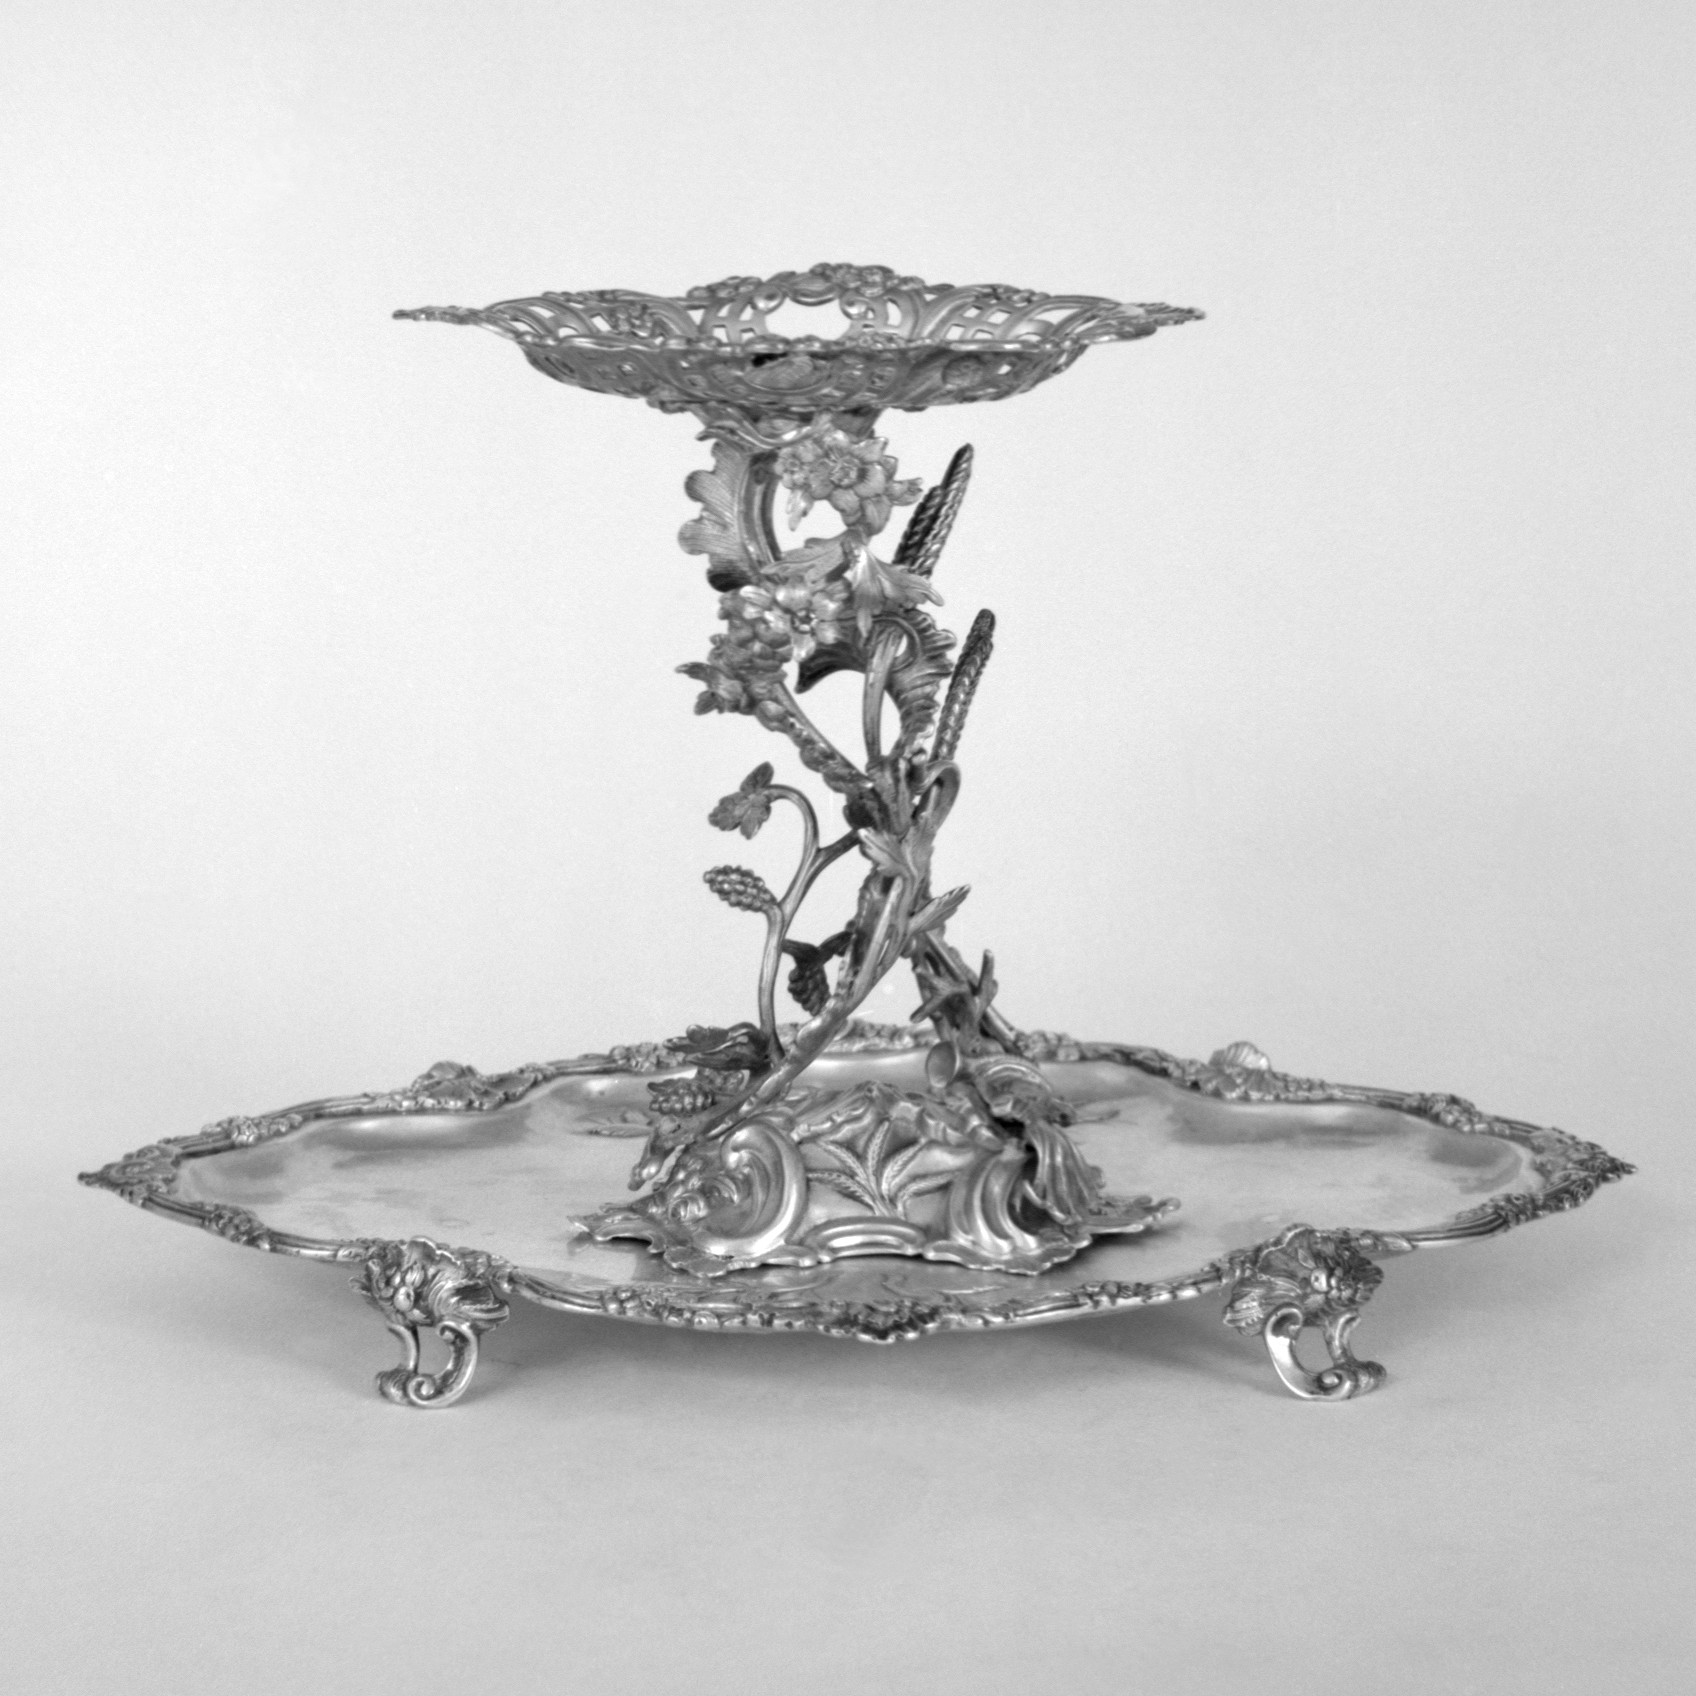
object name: centerpiece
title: Table centerpiece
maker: johann jakob adam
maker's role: maker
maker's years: 1720-1791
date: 1765-1767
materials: silver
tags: flowers